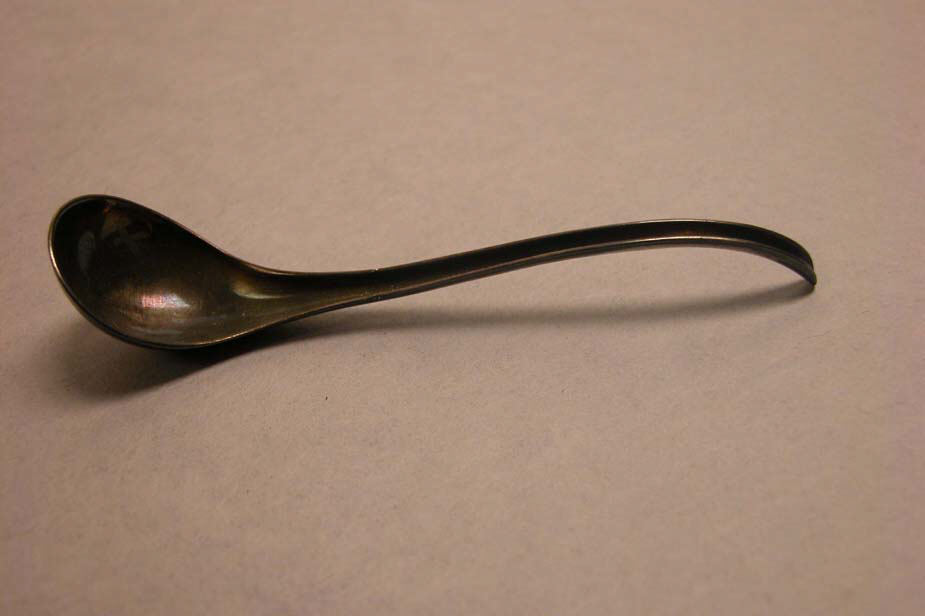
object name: spoon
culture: japanese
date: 1801-1900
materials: silver